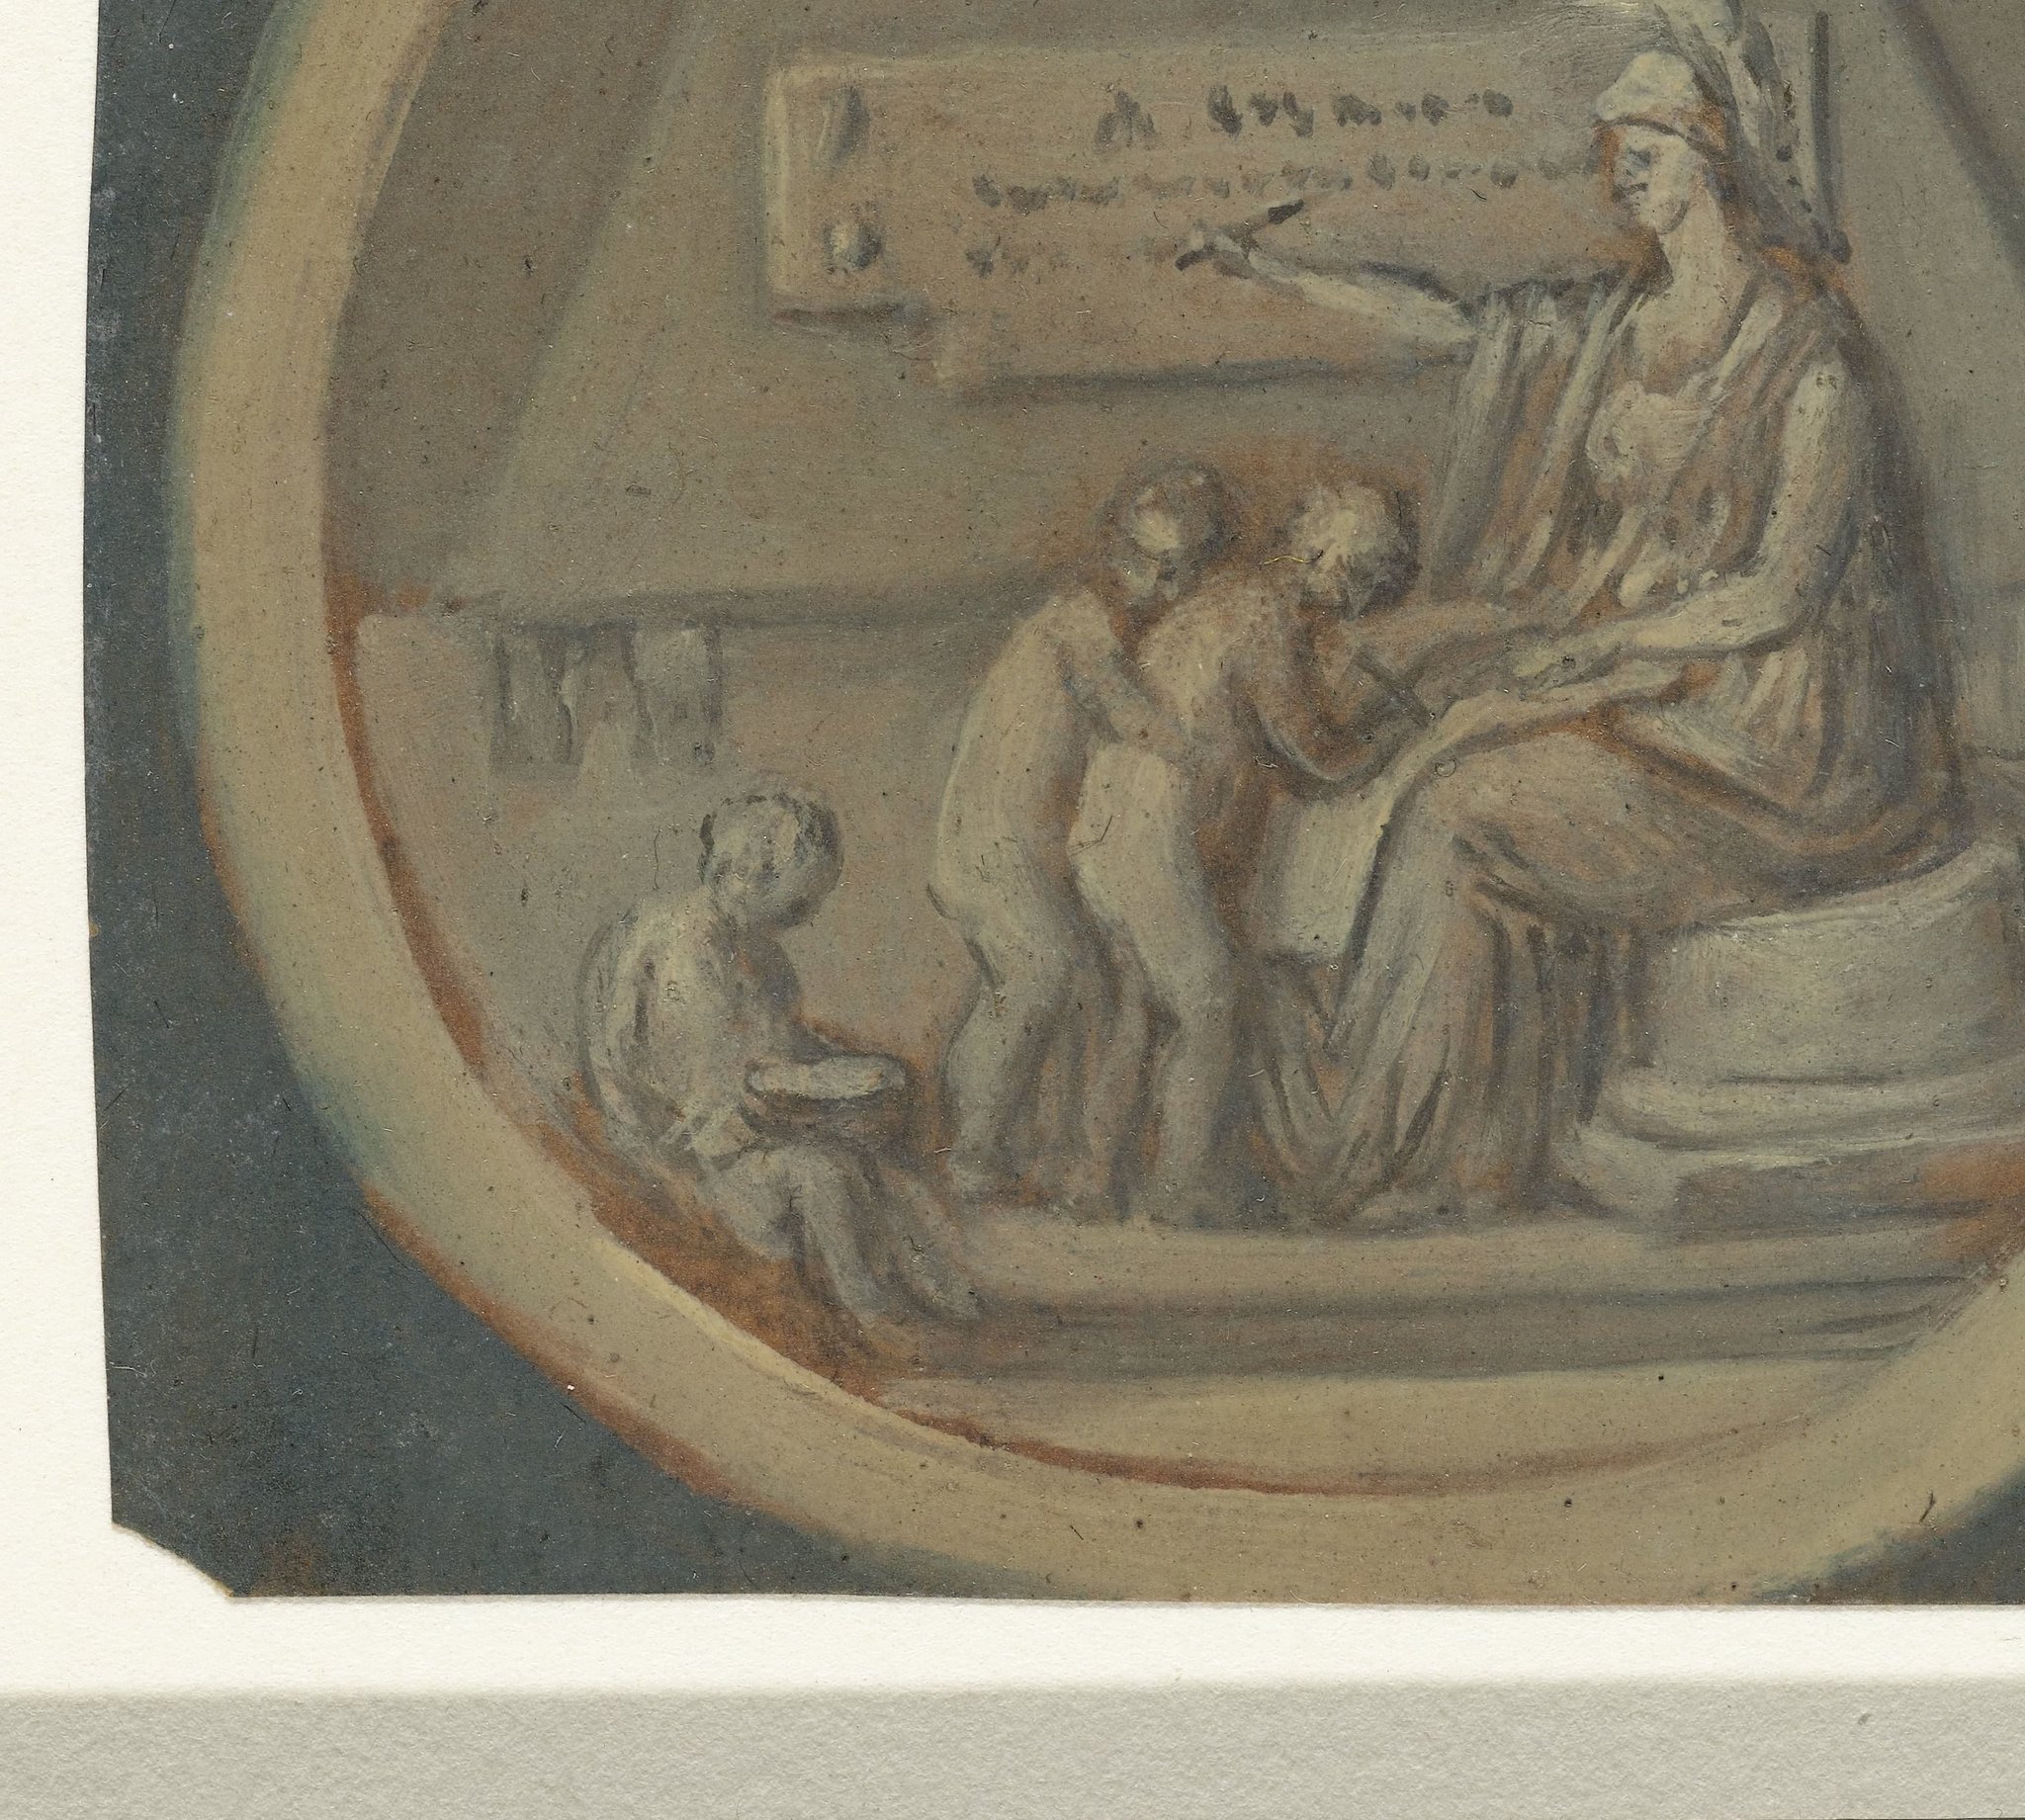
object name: drawing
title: Vignet met Minerva onderwijzend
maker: Anonymous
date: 1700-1800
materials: oil, paper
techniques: brush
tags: minerva as patroness, art